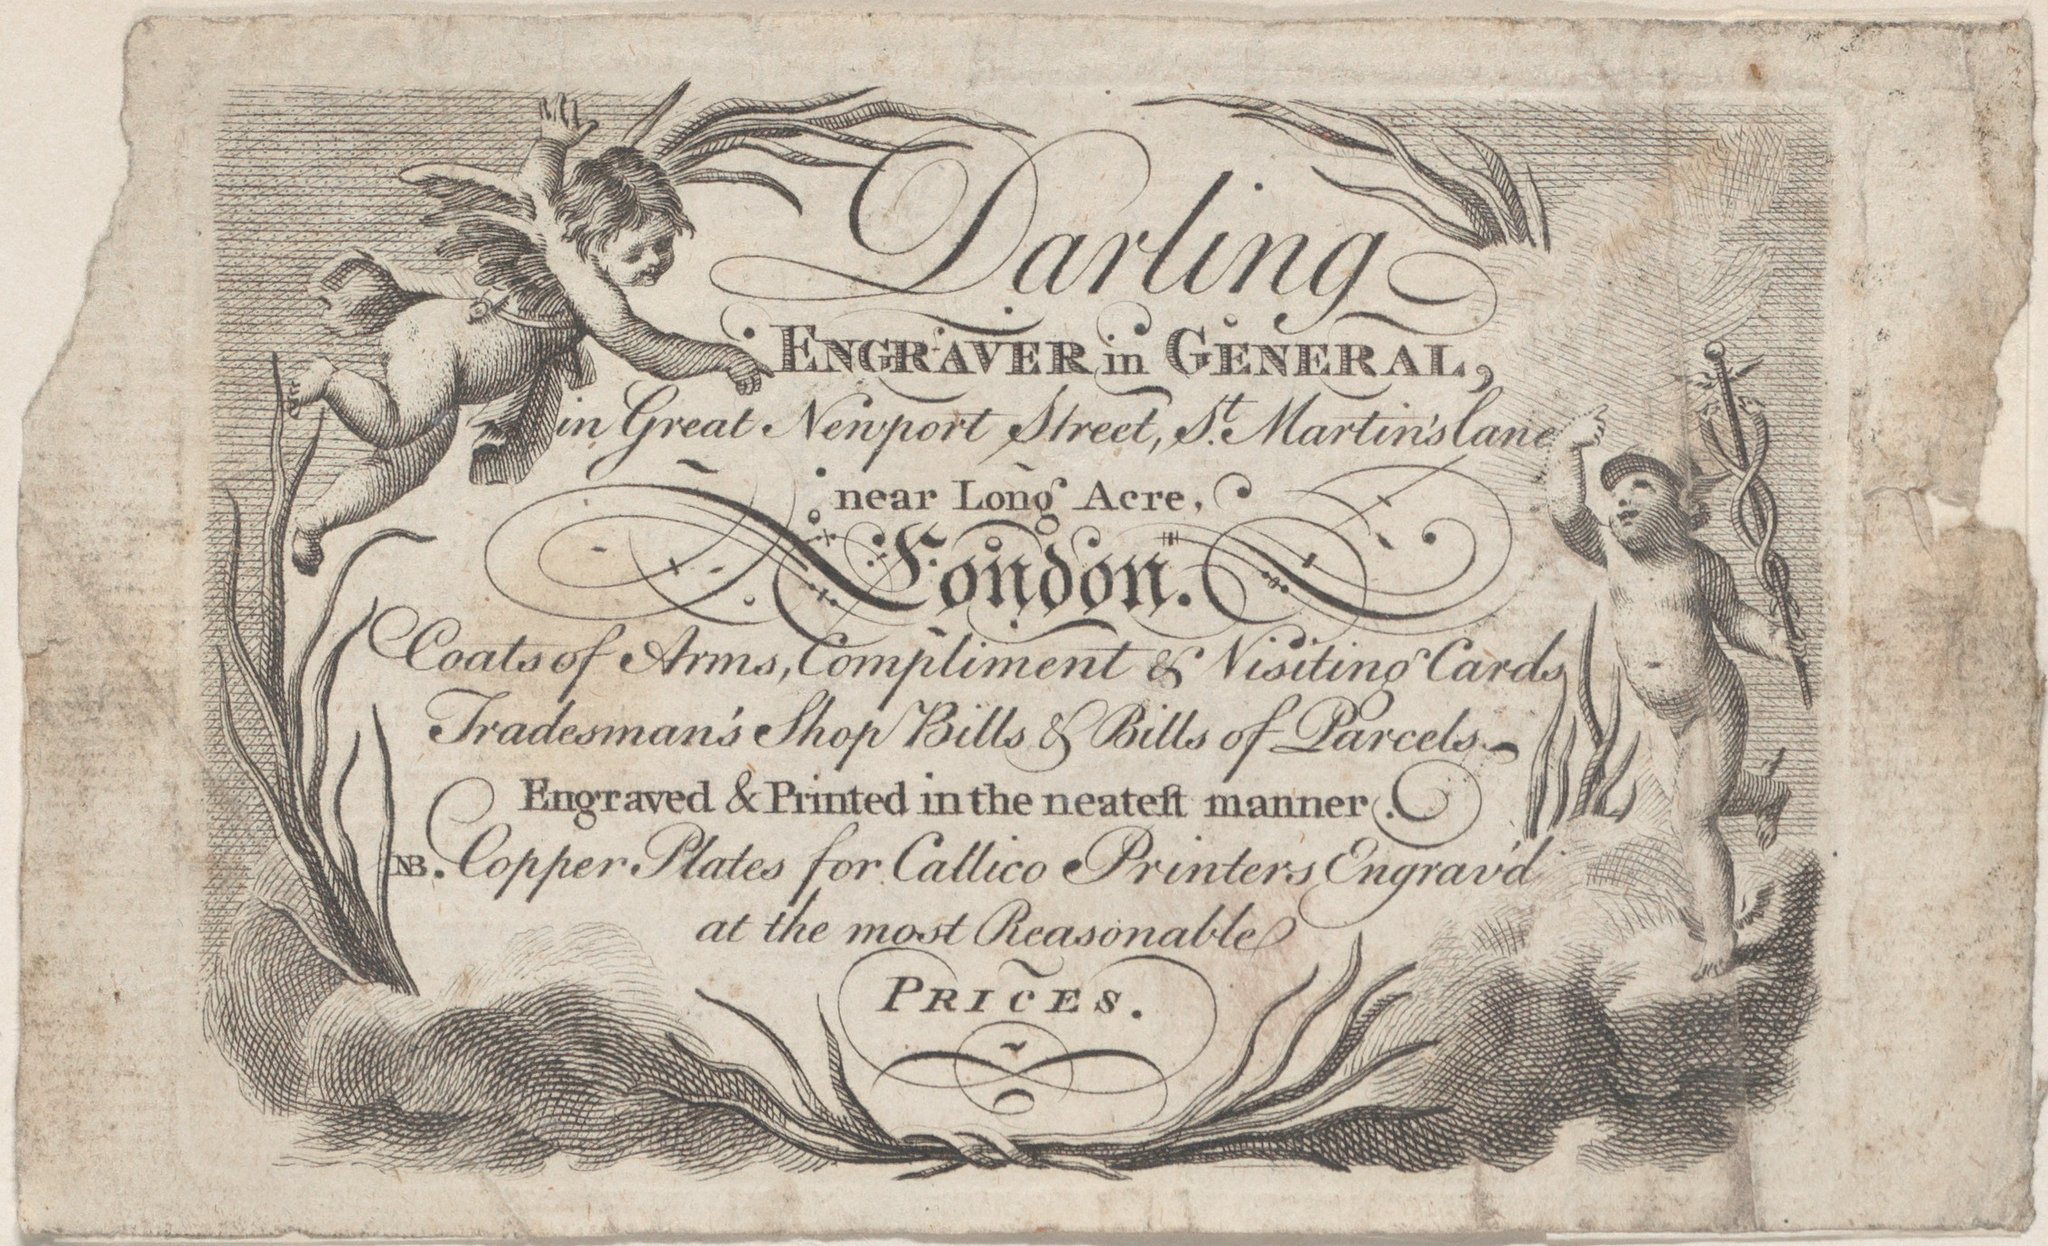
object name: print, trade card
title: Trade Card for William Darling, Engraver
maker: anonymous, british, 18th century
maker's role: artist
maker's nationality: british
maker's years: 1700-1800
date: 1701-1800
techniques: engraving